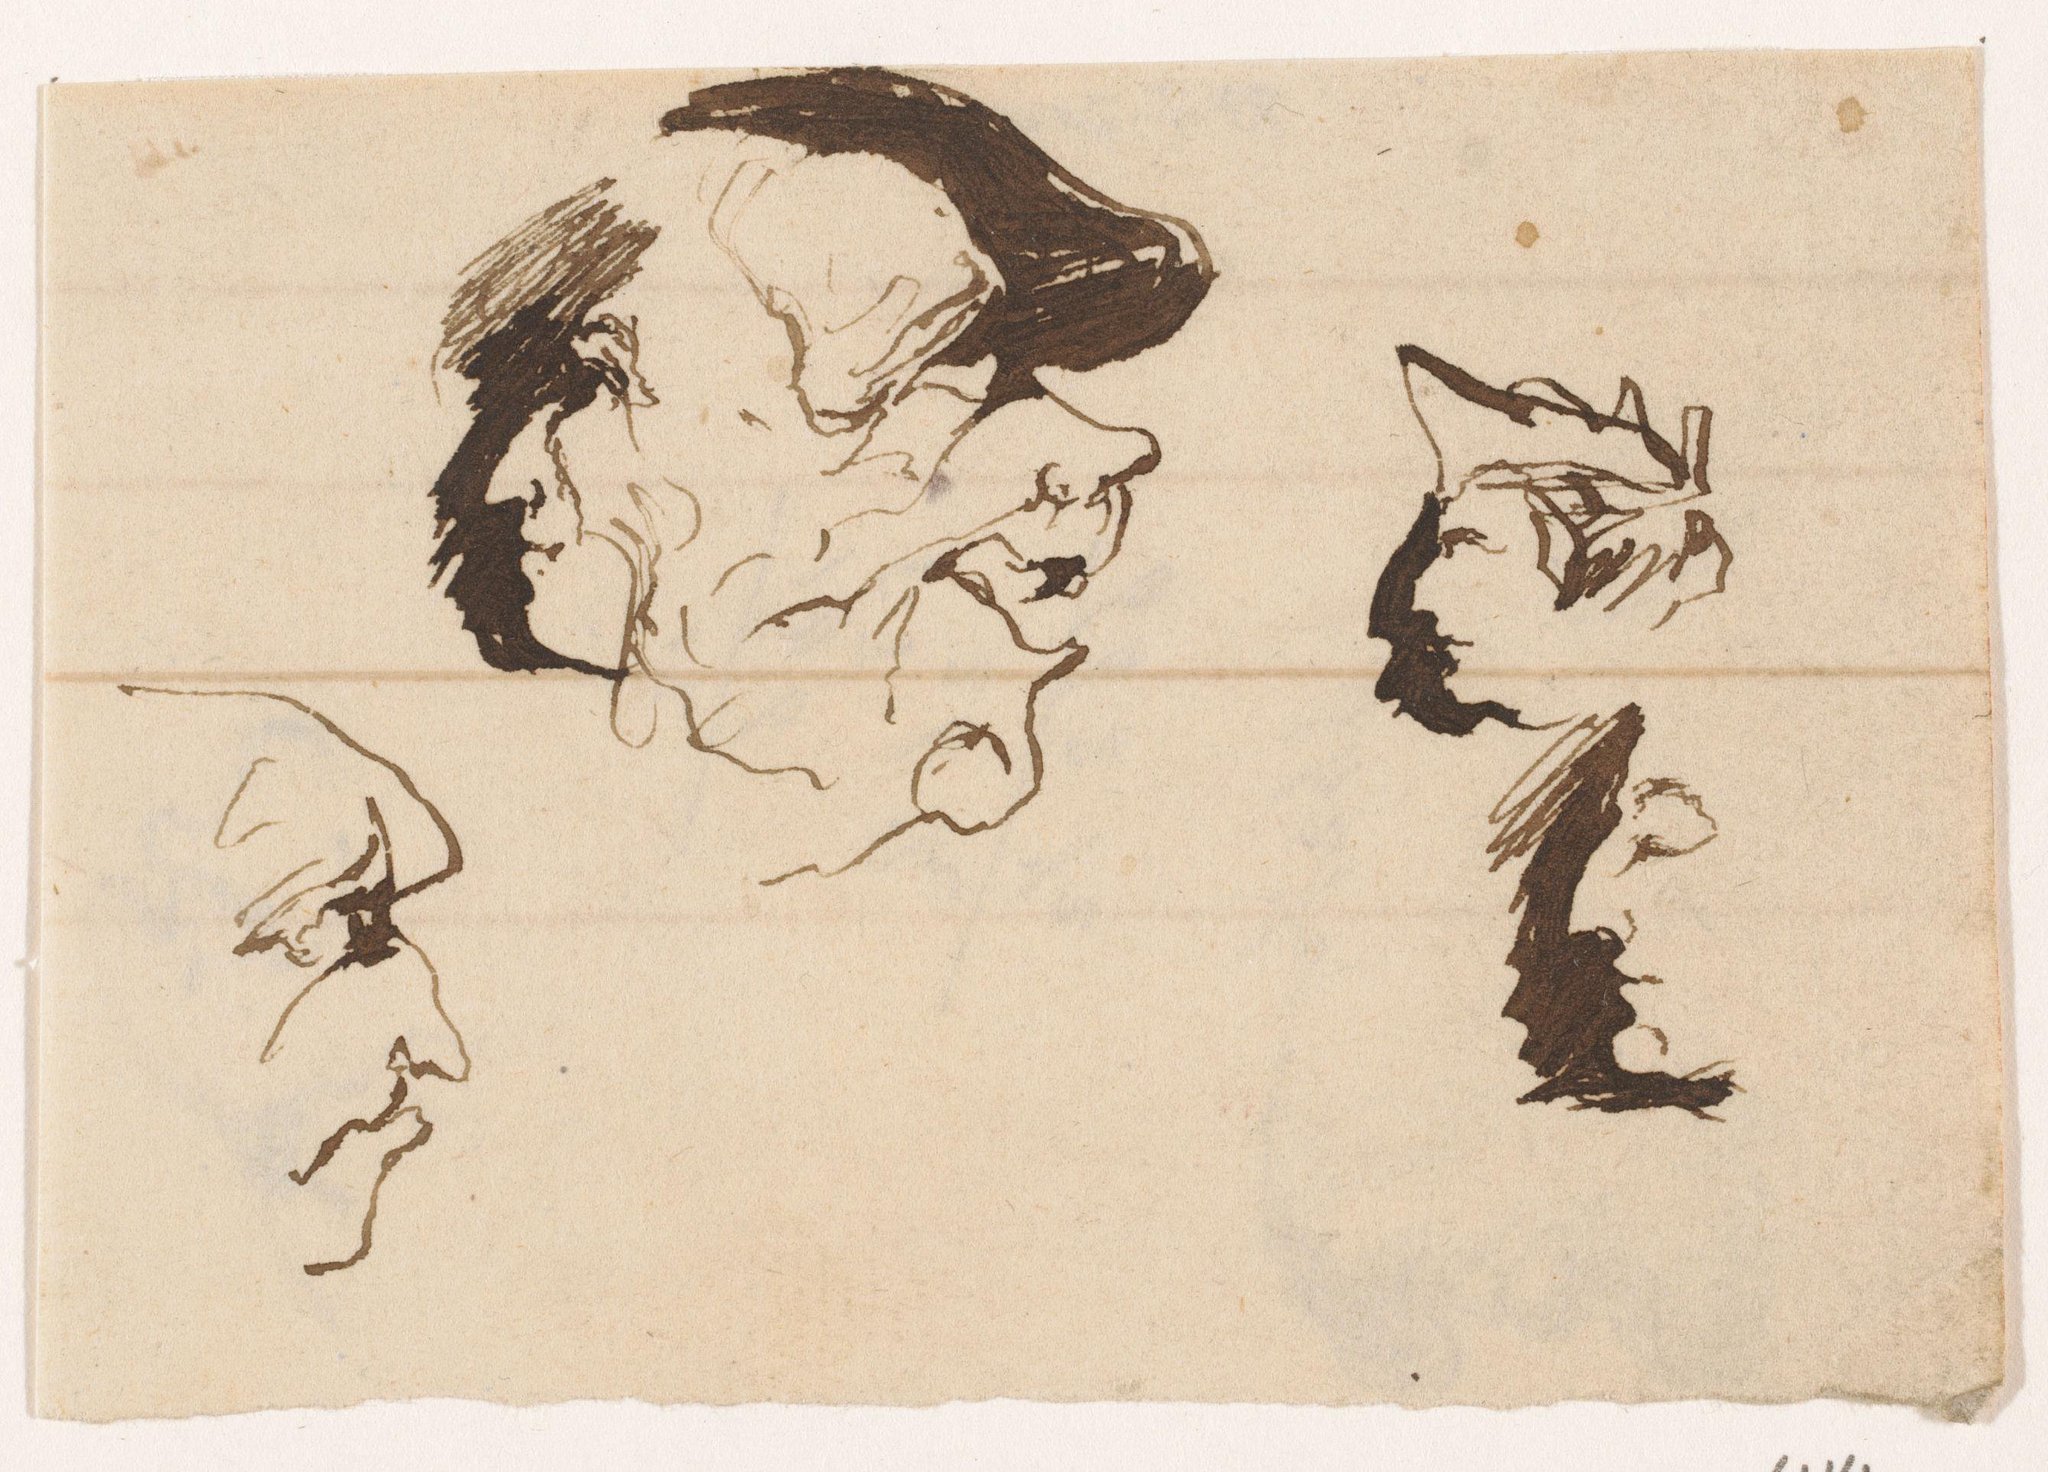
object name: drawing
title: Koppen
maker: johannes tavenraat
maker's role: draughtsman, painter, print maker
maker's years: 1809-1881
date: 1840-1880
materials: ink, paper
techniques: pen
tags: caricatures (human types)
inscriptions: collector's mark: Lugt 2228